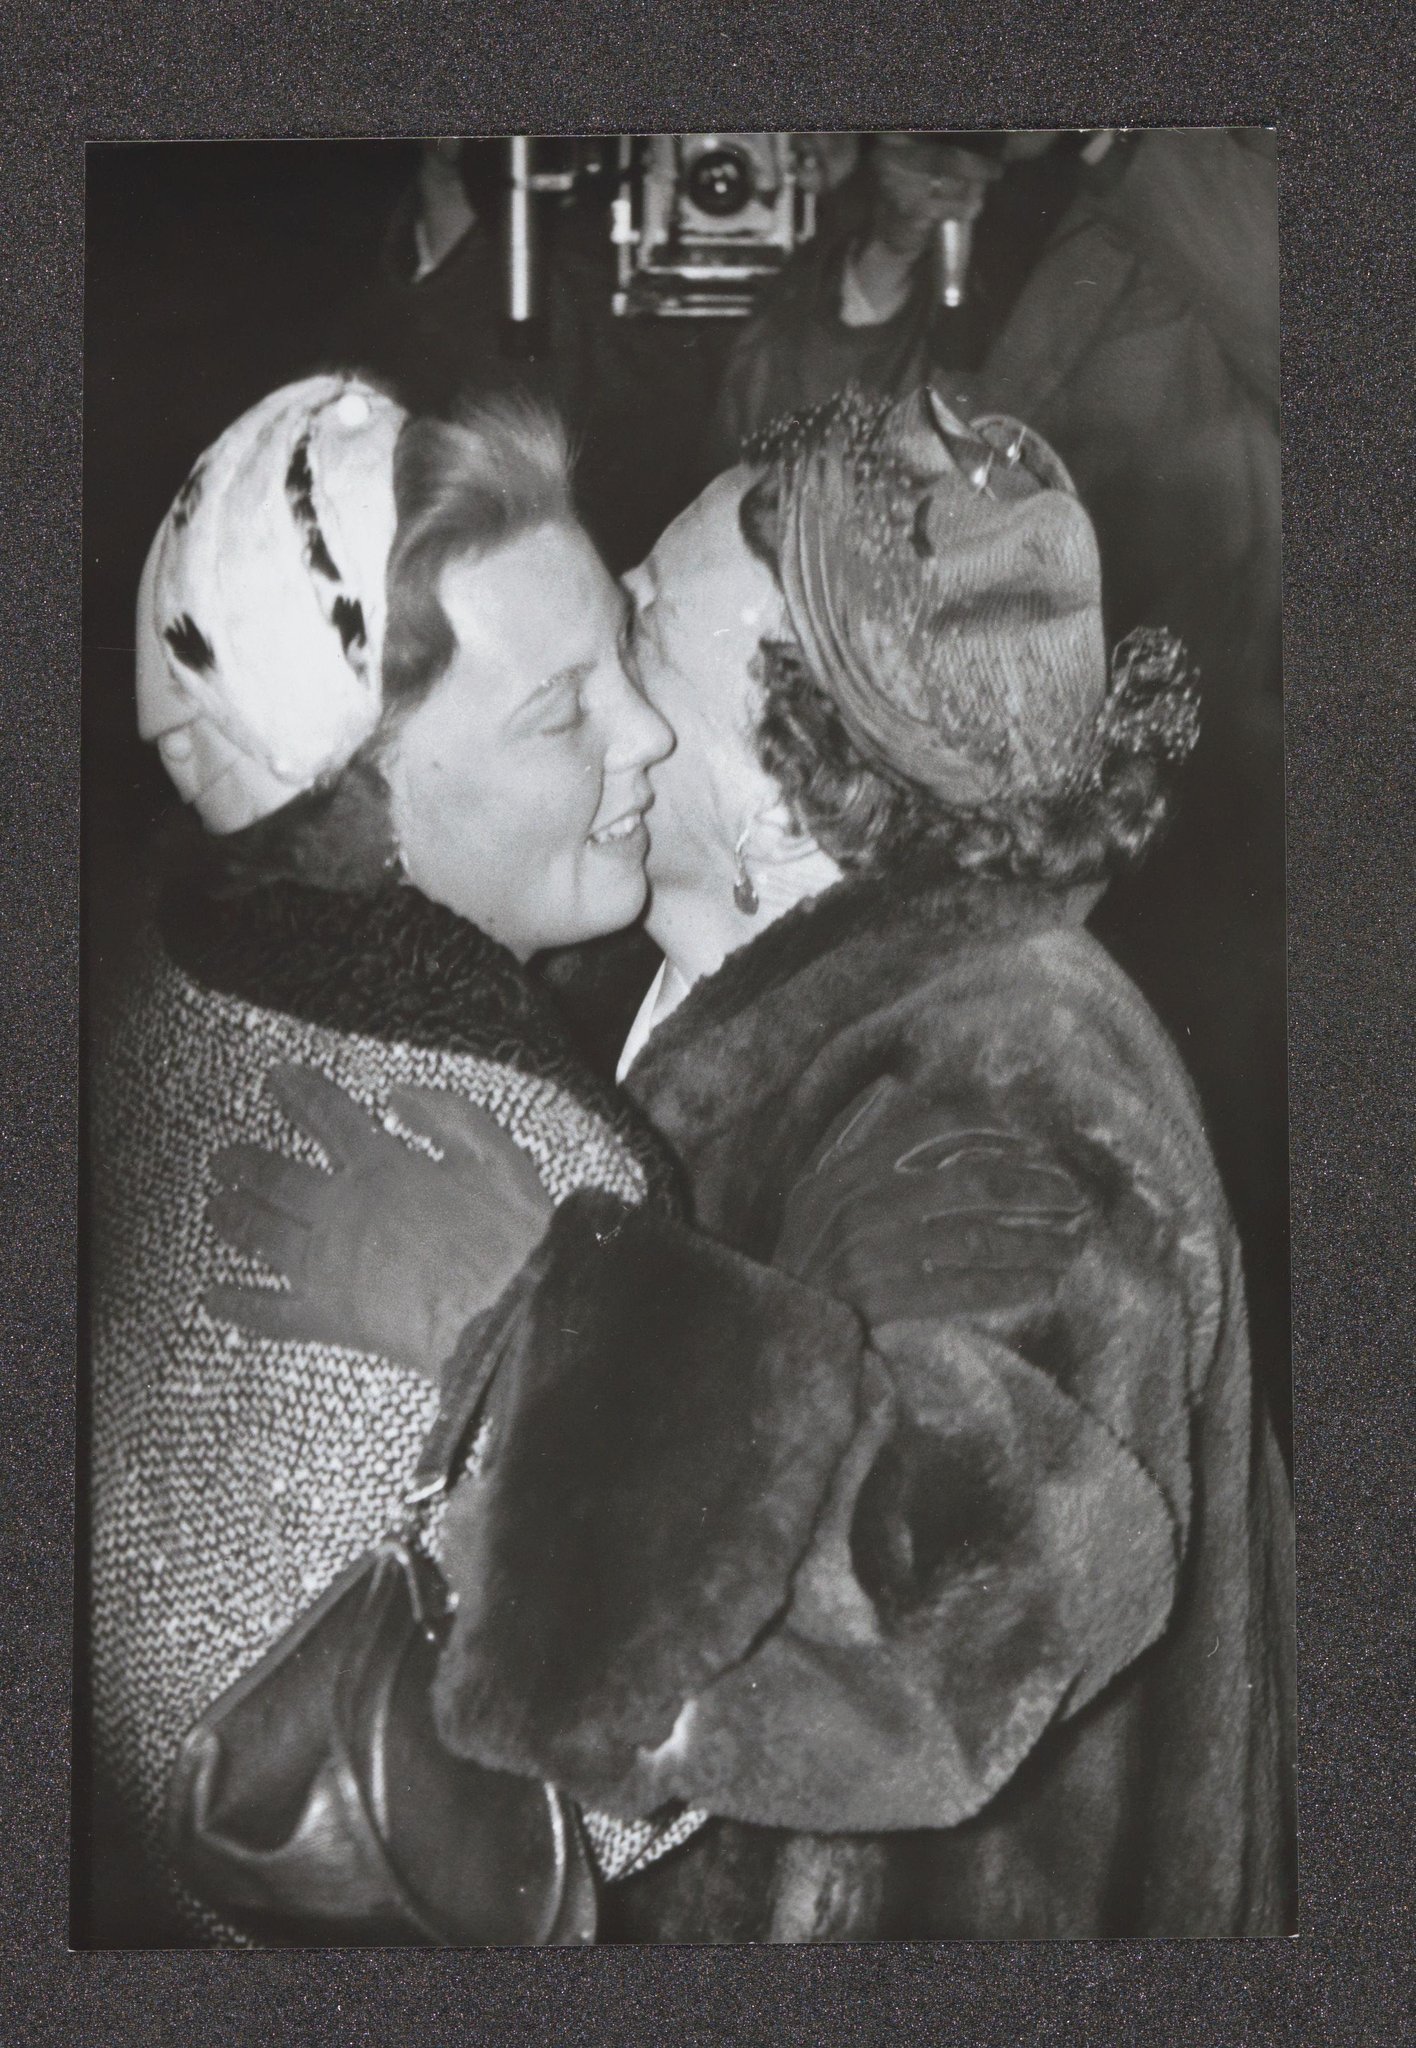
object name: photograph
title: Begroeting van prinses Beatrix door koningin Juliana op de 21ste verjaardag van de eerste (die daarmee meerderjarig was geworden), op Schiphol, na een reis door Beatrix naar de koloniën in de West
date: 1959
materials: paper, photographic support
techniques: gelatin silver print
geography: netherlands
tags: beatrix (koningin der nederlanden), the hague, juliana of the netherlands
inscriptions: annotation: ‘Saturday 21st,1959, H.R.H. Pr.Beatrix celebrates / Her 21st birthday and thus attains Her Majority. // Picture from the files: H.M.the Queen welcomes / H.R.H.Pr.Beatrix on airport Schiphol, after the / Voyage of Pr.Beatrix in West Indies. /./ P OTO-ANEFO 28-1-1959’